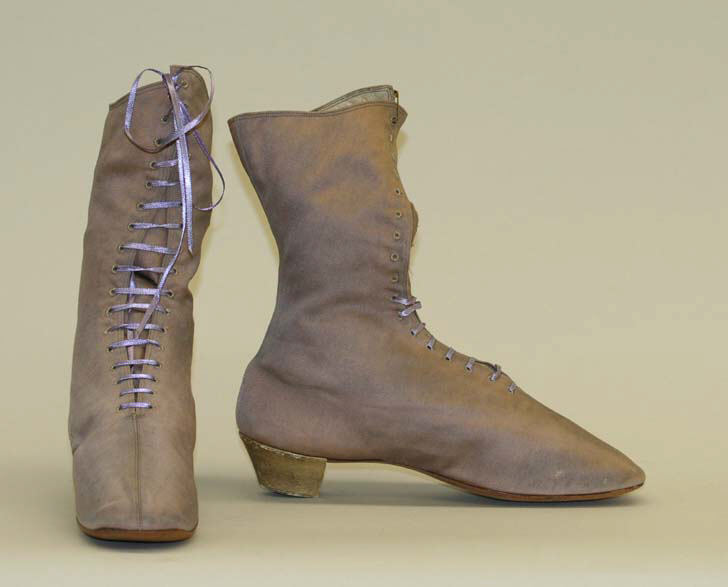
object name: shoe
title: Shoes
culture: american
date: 1850-1860